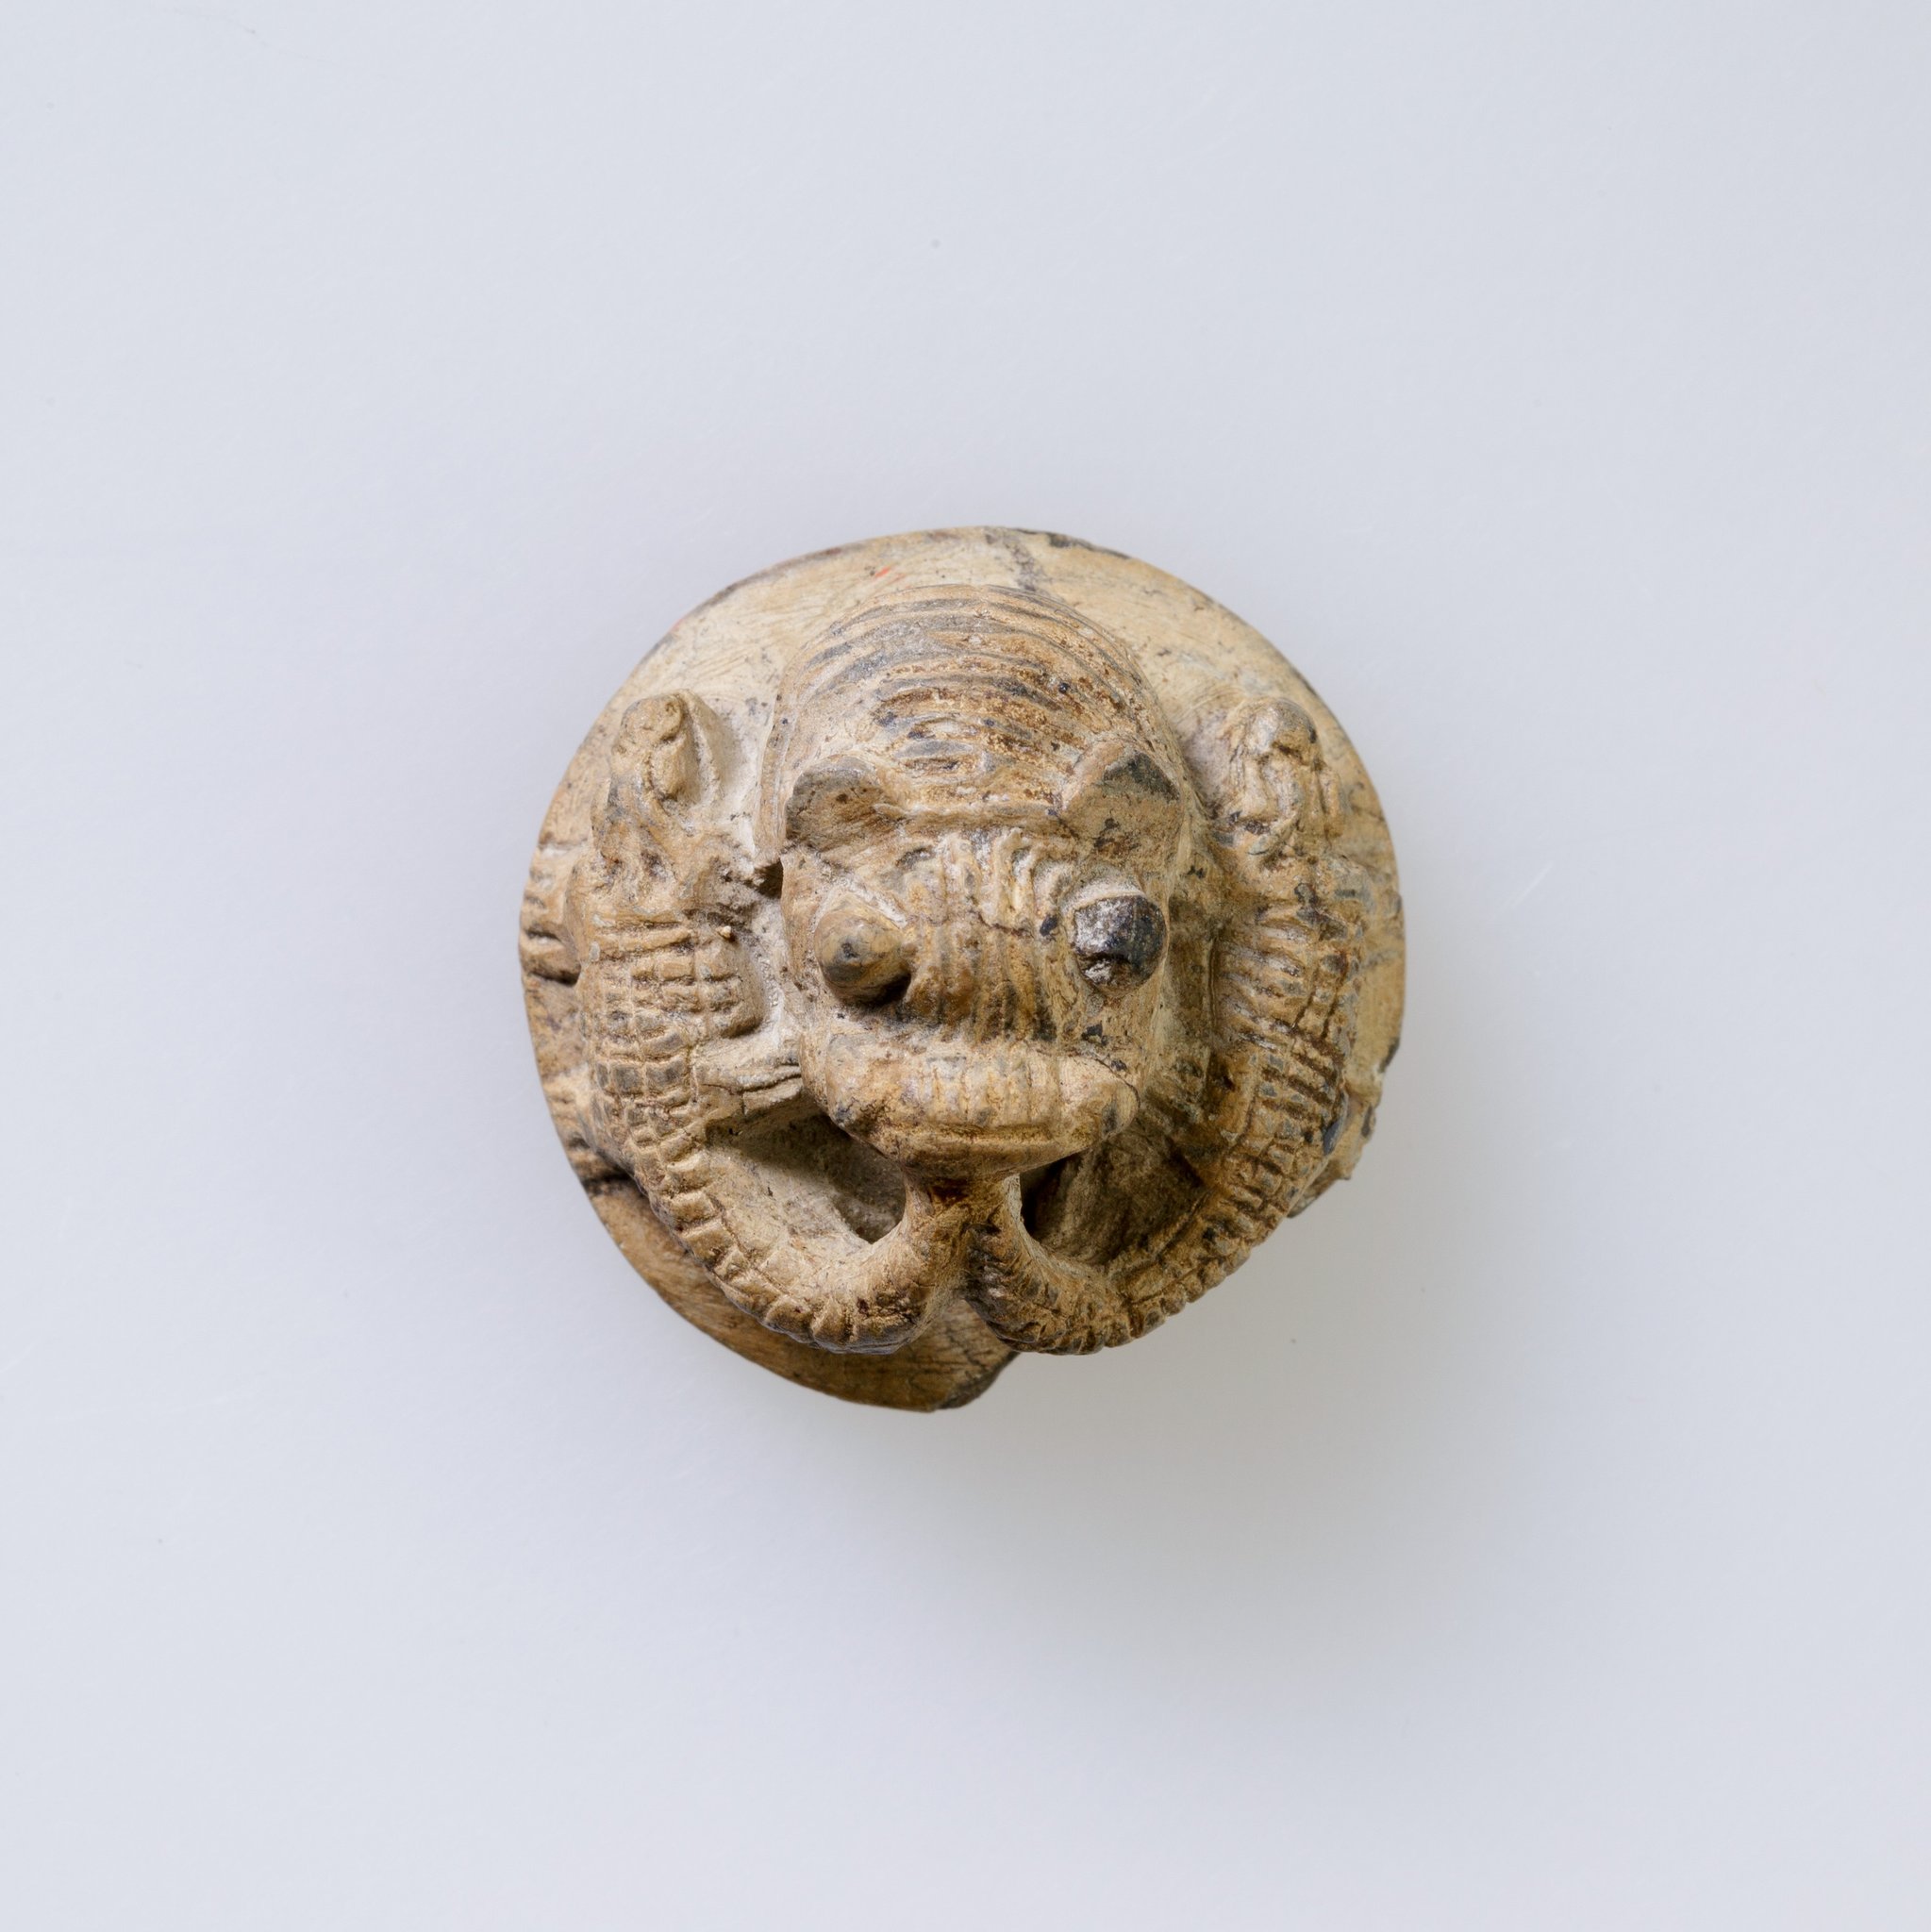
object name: amulet, hippopotamus, ibex head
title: Hippopotamus-Head Design Amulet Inscribed With Four Linked Ibex Heads.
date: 2150-2040 BCE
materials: stone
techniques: glazing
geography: egypt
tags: crocodiles,hippos